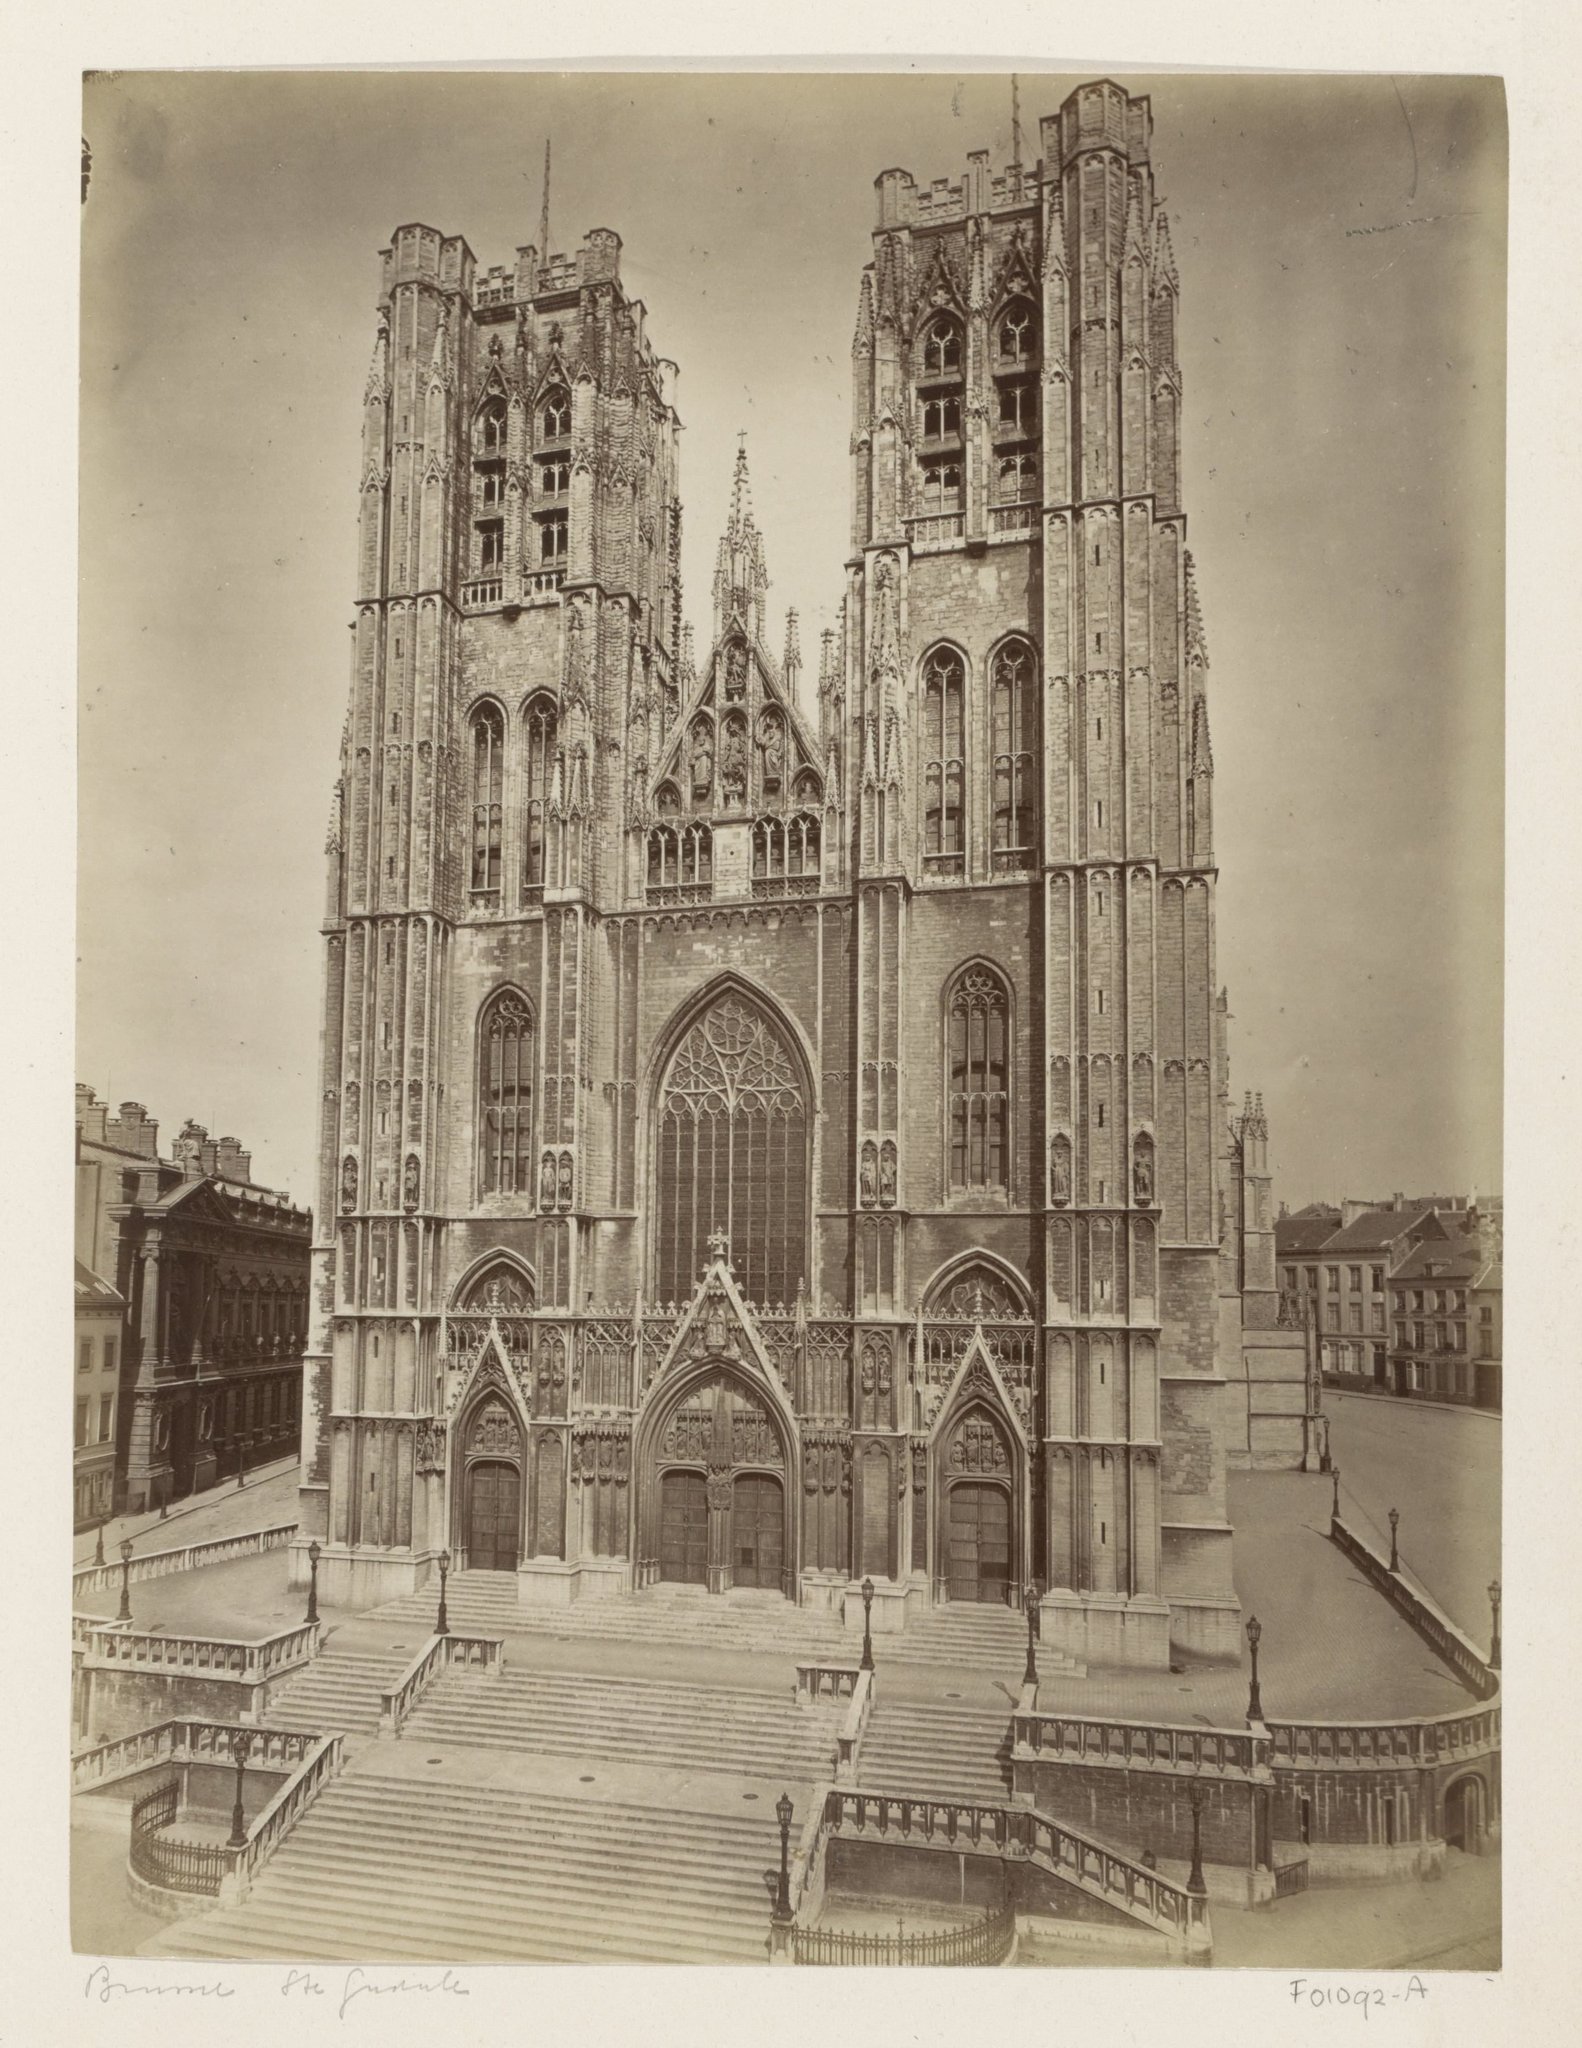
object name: photograph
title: Exterieur van de Kathedraal van Sint-Michiel en Sint-Goedele in Brussel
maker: Anonymous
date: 1880-1900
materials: cardboard, paper, photographic support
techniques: albumen print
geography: brussels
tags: church (exterior), parts of church exterior and annexes: tower, brussels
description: Onderdeel van Reisalbum met foto's van bezienswaardigheden in België en Frankrijk.